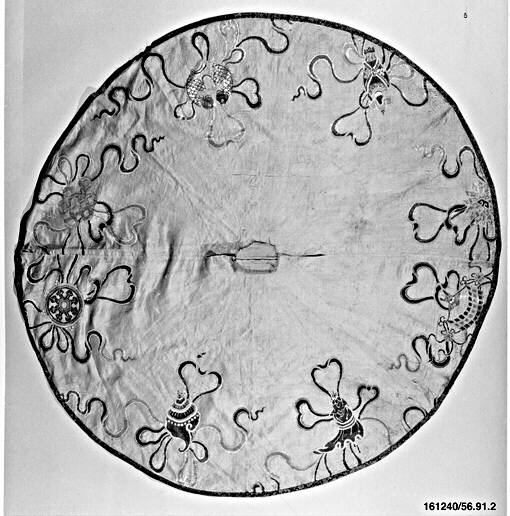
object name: parasol cover, buddhist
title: Buddhist Parasol Cover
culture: chinese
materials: metal thread, silk